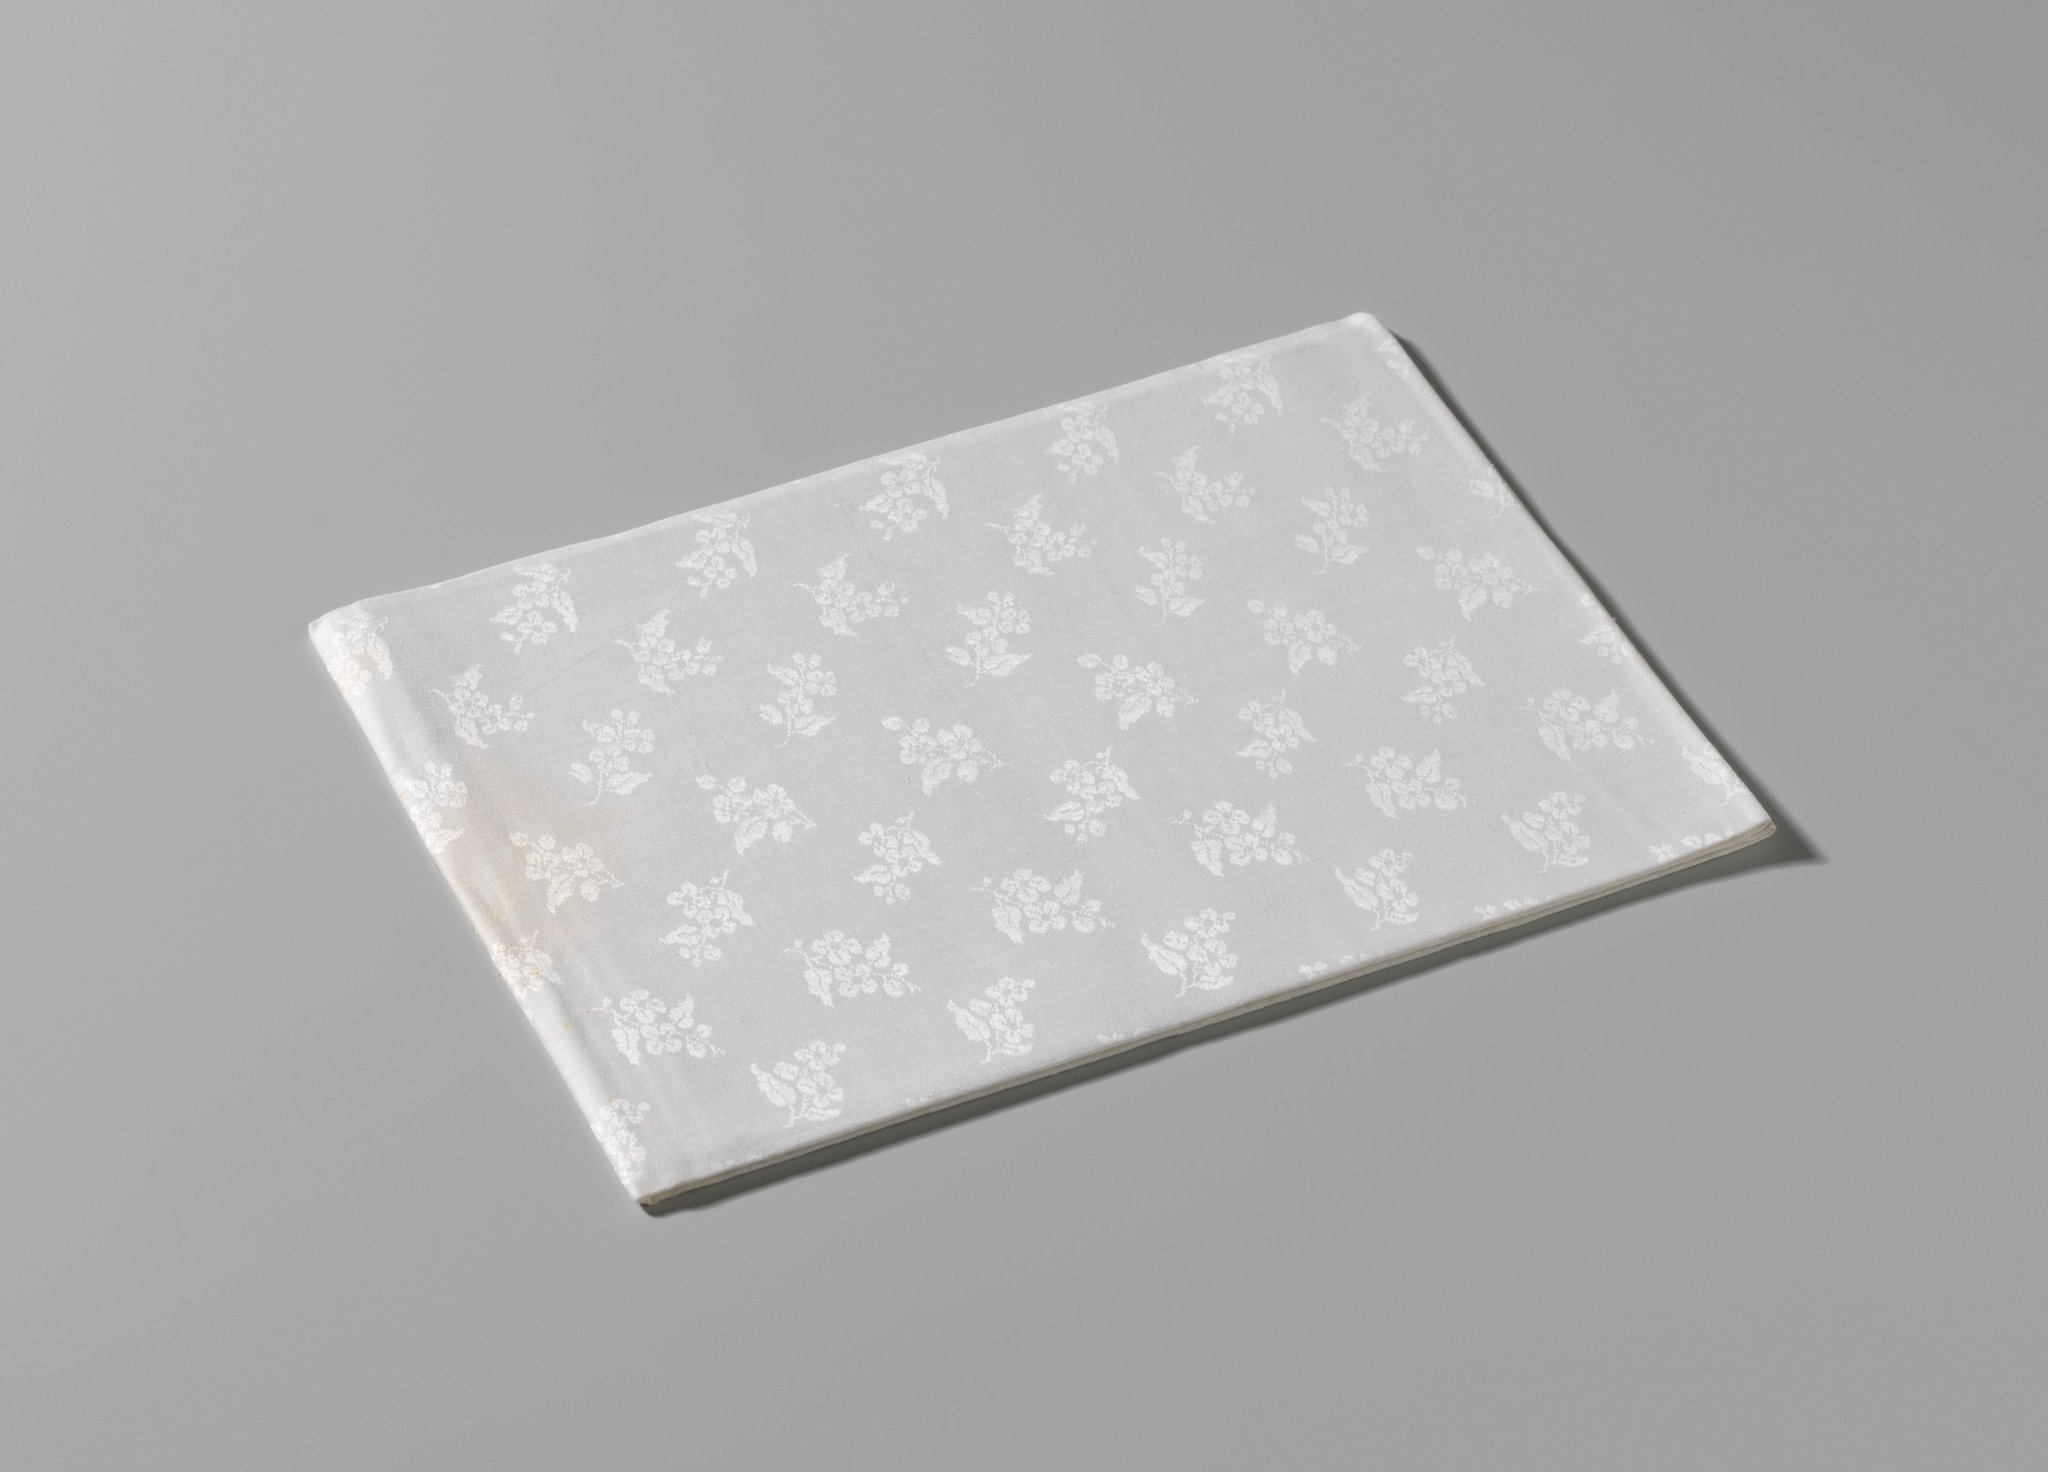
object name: napkin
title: Servet met strooibloemen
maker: Anonymous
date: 1700-1899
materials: linen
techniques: damask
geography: saxony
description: Vergelijk E. Kumsch, Leinendamastmuster des XVII. und XVIII. Jahrhunderts, Dresden 1891, Taf. 9,1.